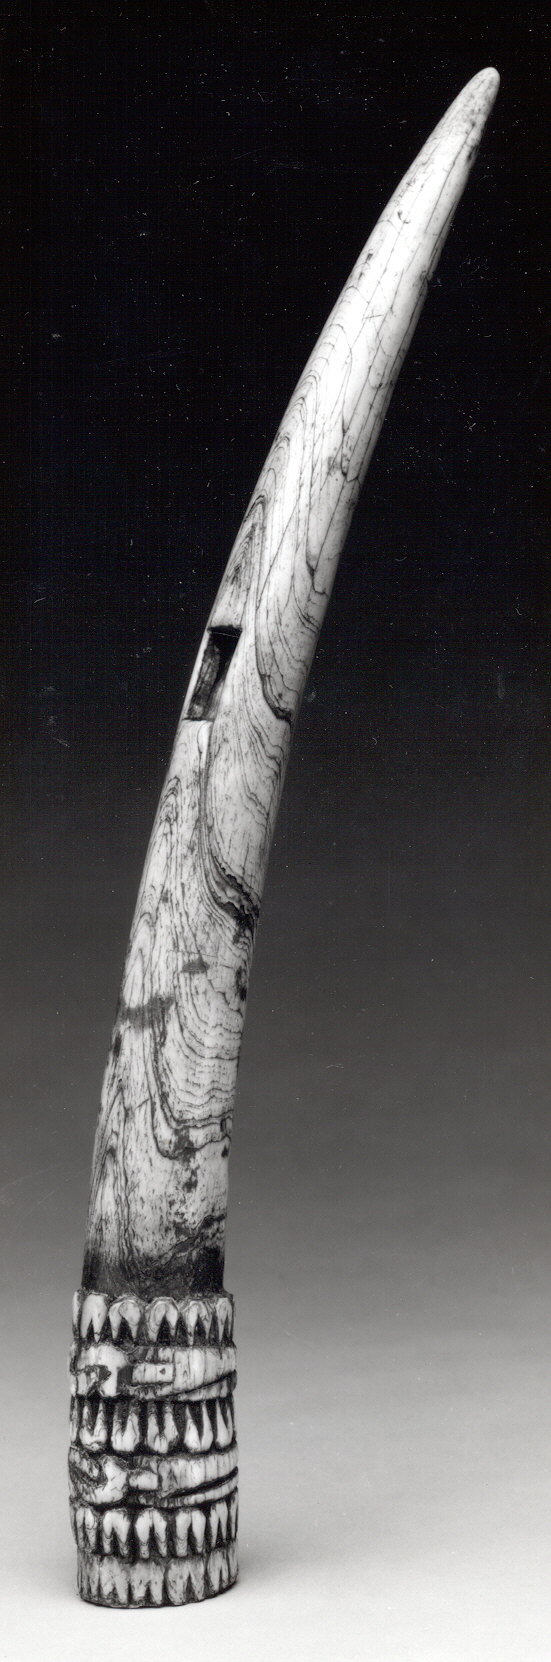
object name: trumpet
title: Side-blown Trumpet (Oko)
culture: edo period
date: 1701-1900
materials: ivory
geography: nigeria